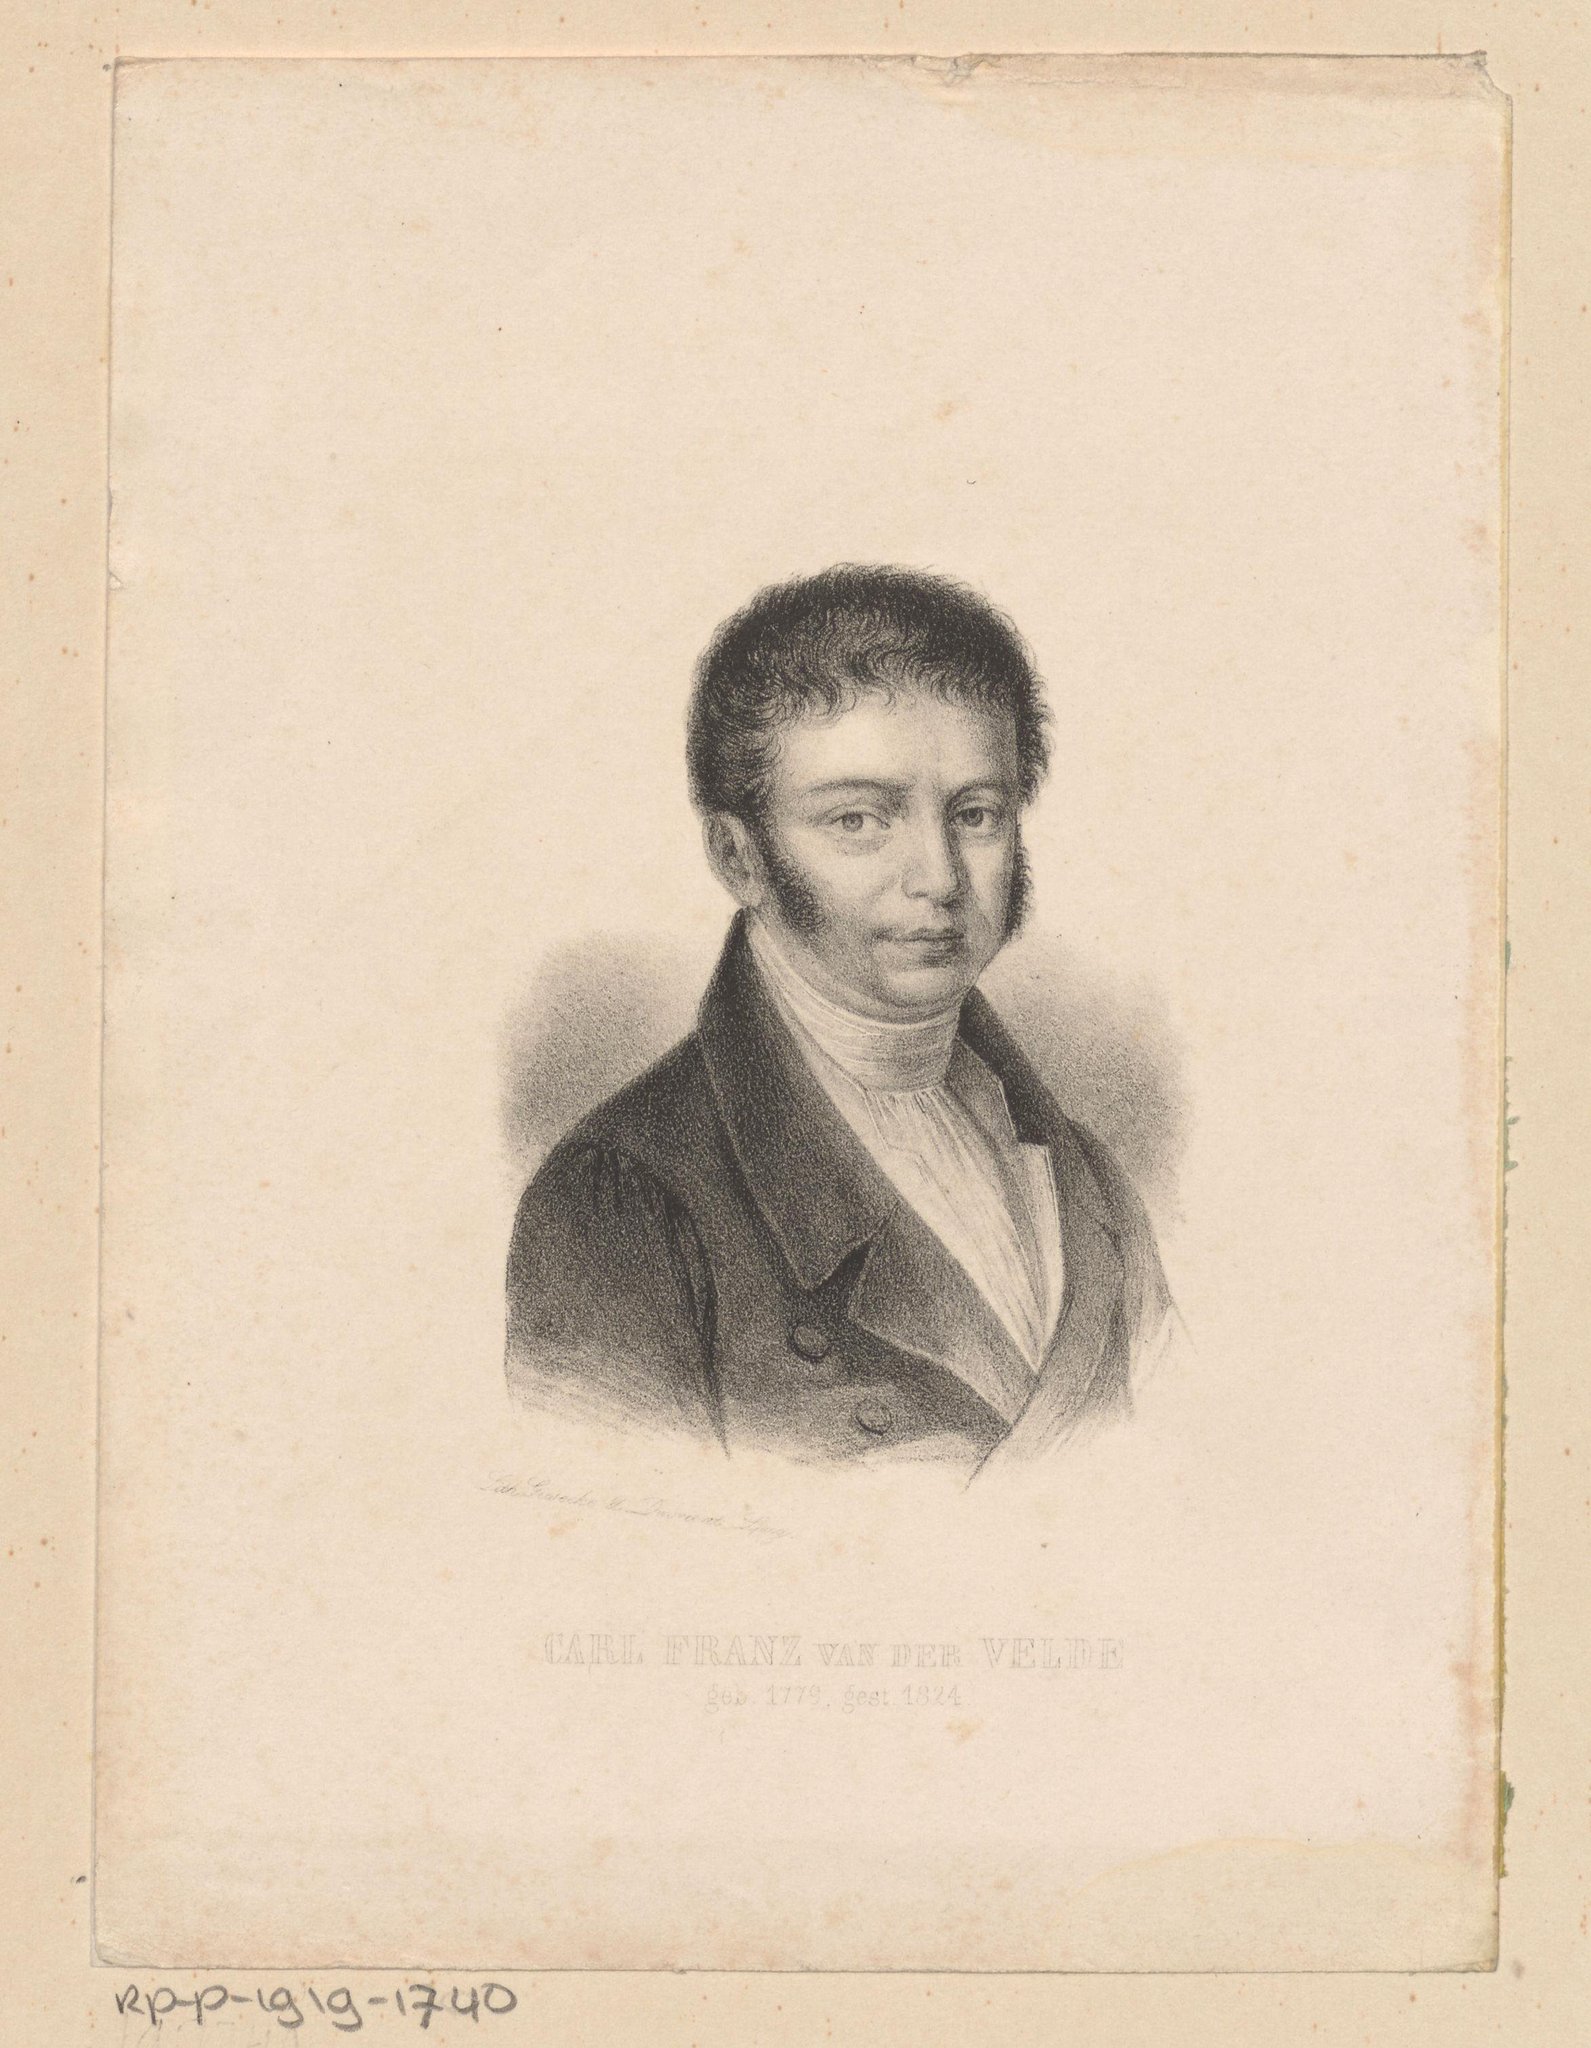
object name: print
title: Portret van Carl Franz van der Velde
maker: Anonymous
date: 1824-1870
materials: paper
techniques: lithograph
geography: germany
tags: historical persons, lawyer, attorney at law, portrait of a writer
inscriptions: collector's mark: Lugt 2228